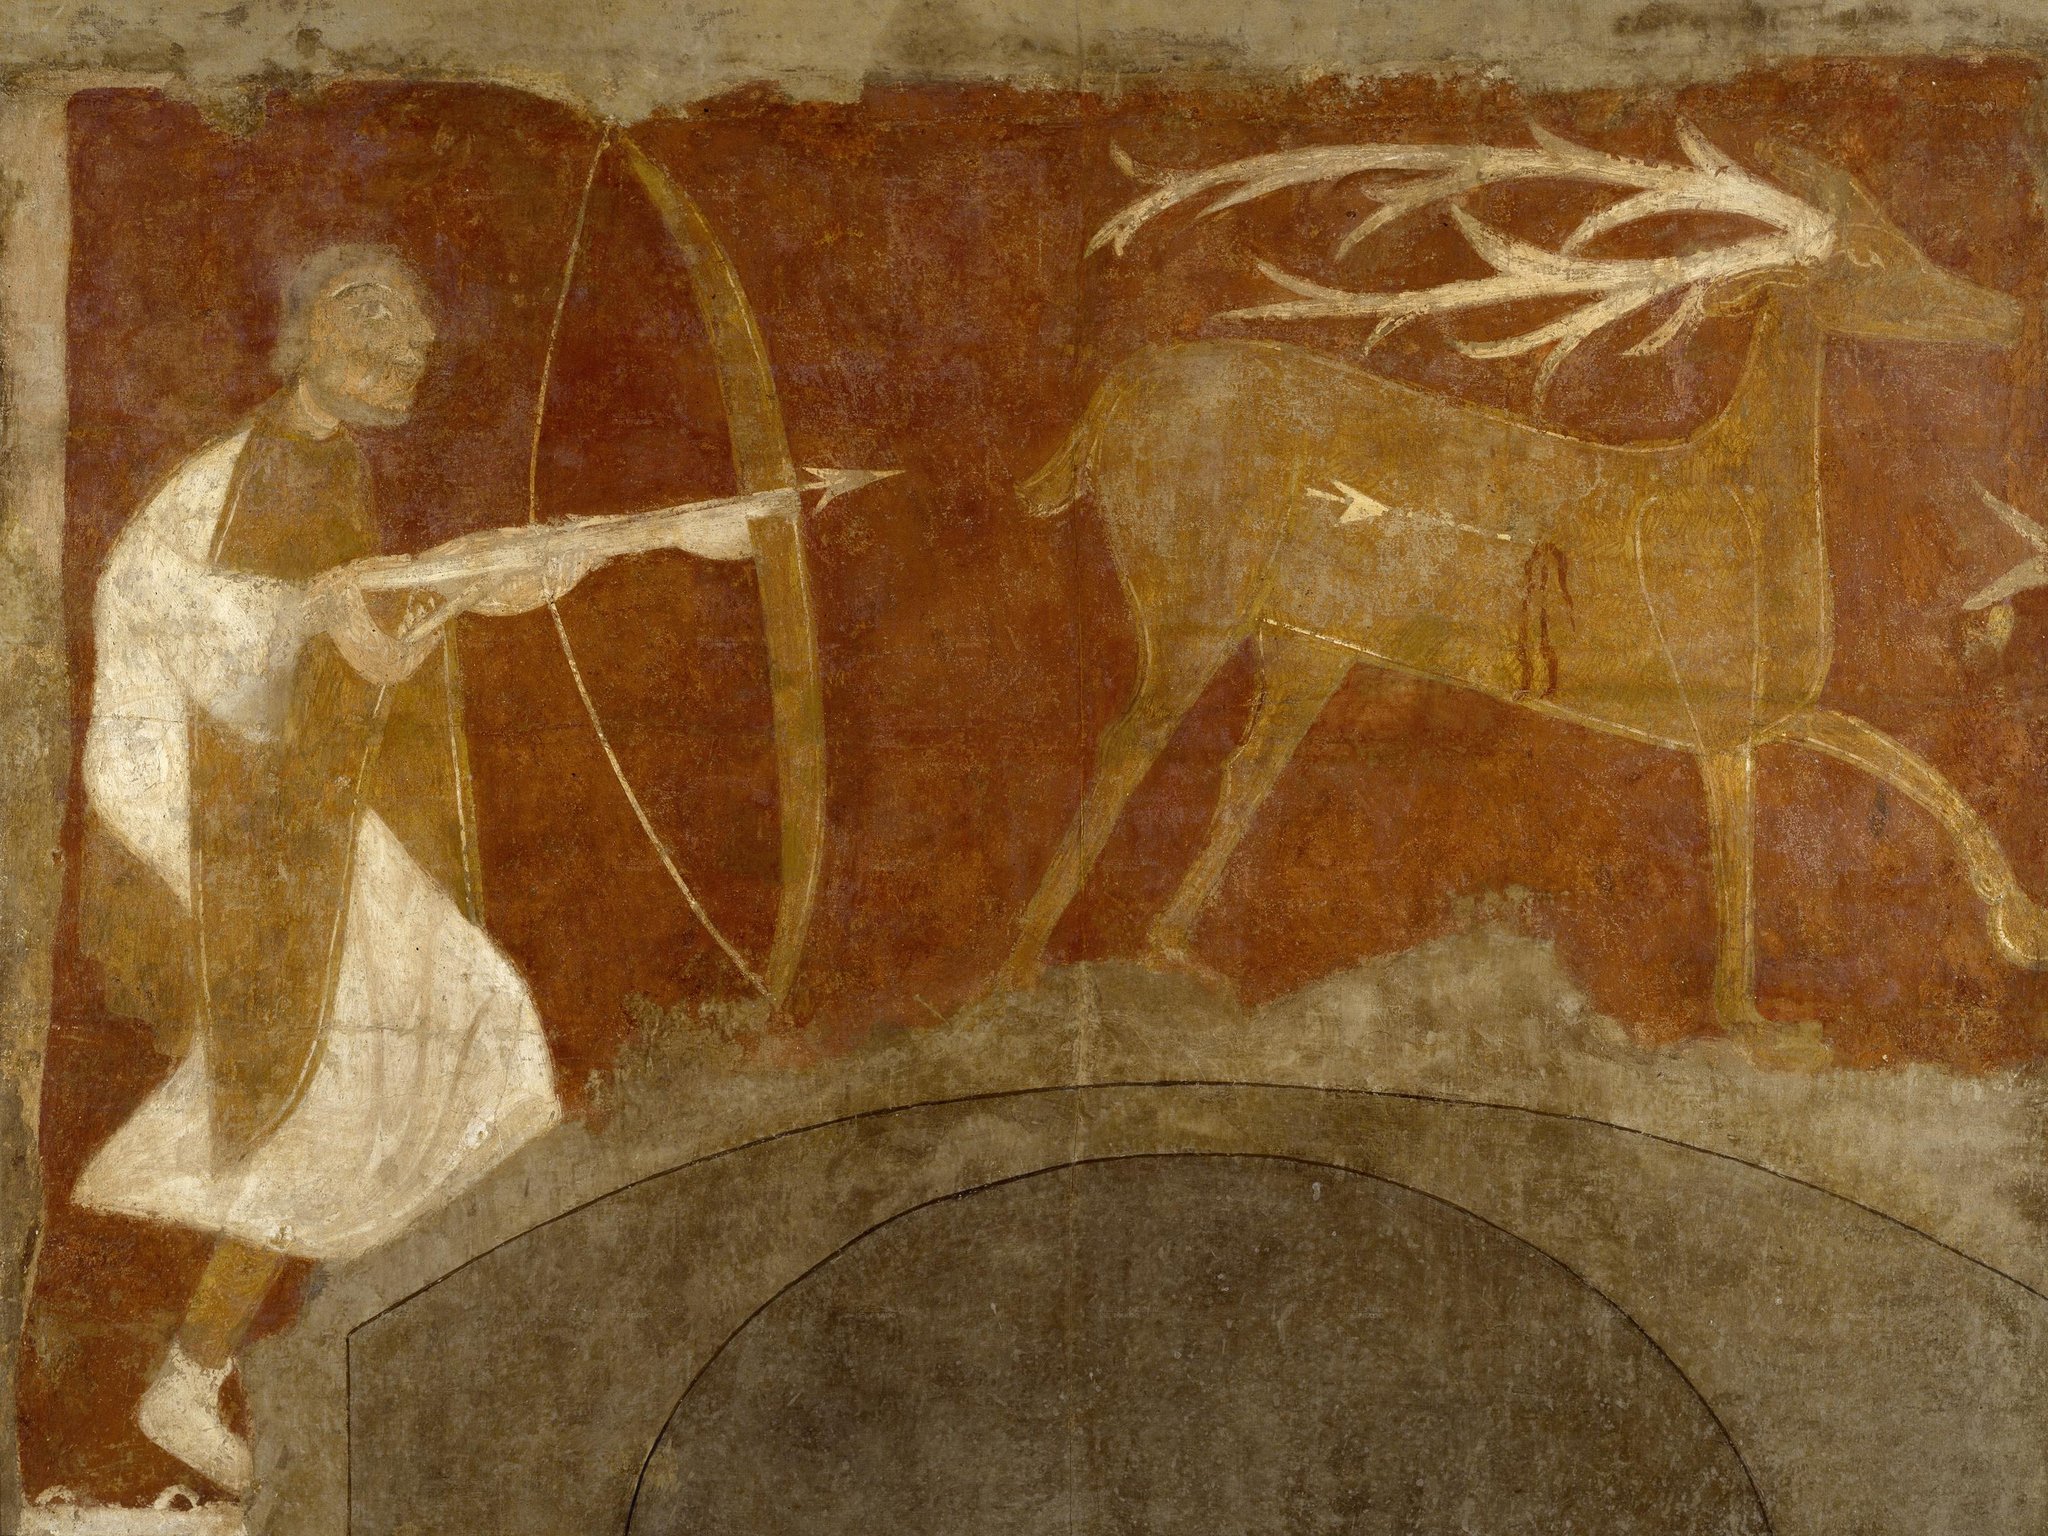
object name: fresco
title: Hunting Scene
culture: spanish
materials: canvas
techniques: fresco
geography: spain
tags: bow and arrow,men,hunting,deer